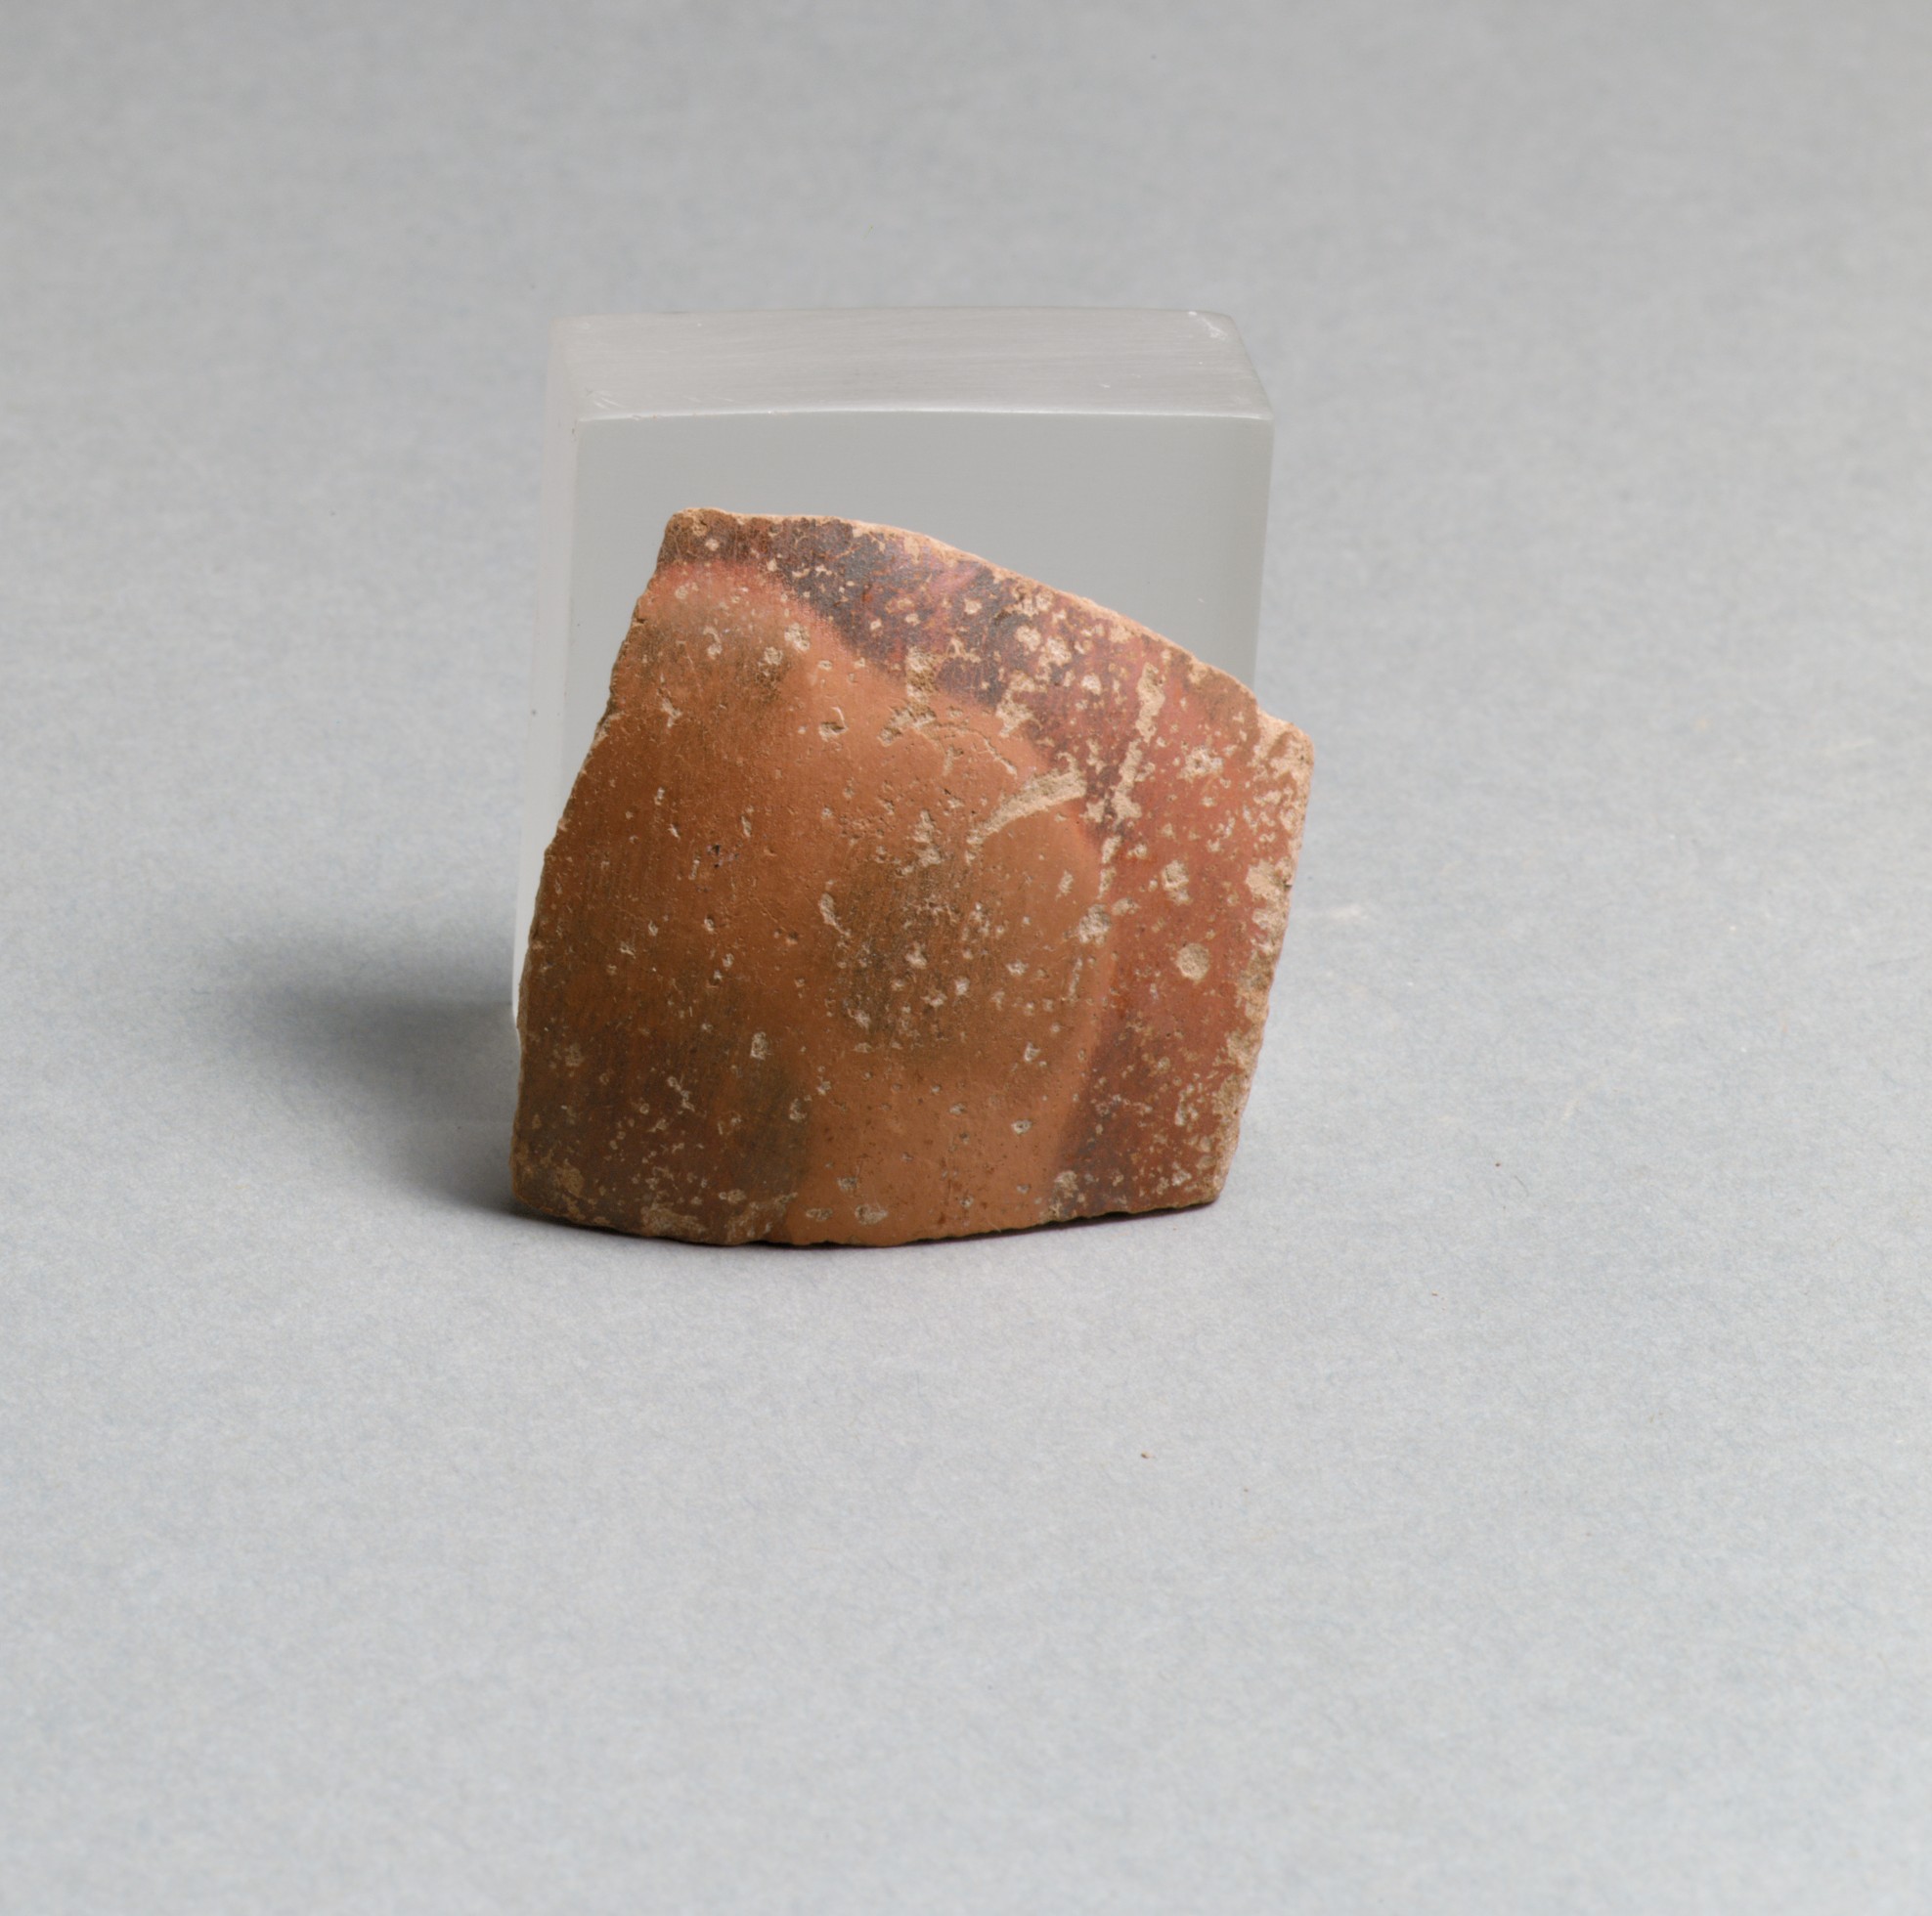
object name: vase fragment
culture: minoan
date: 2600-2000 BCE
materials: terracotta